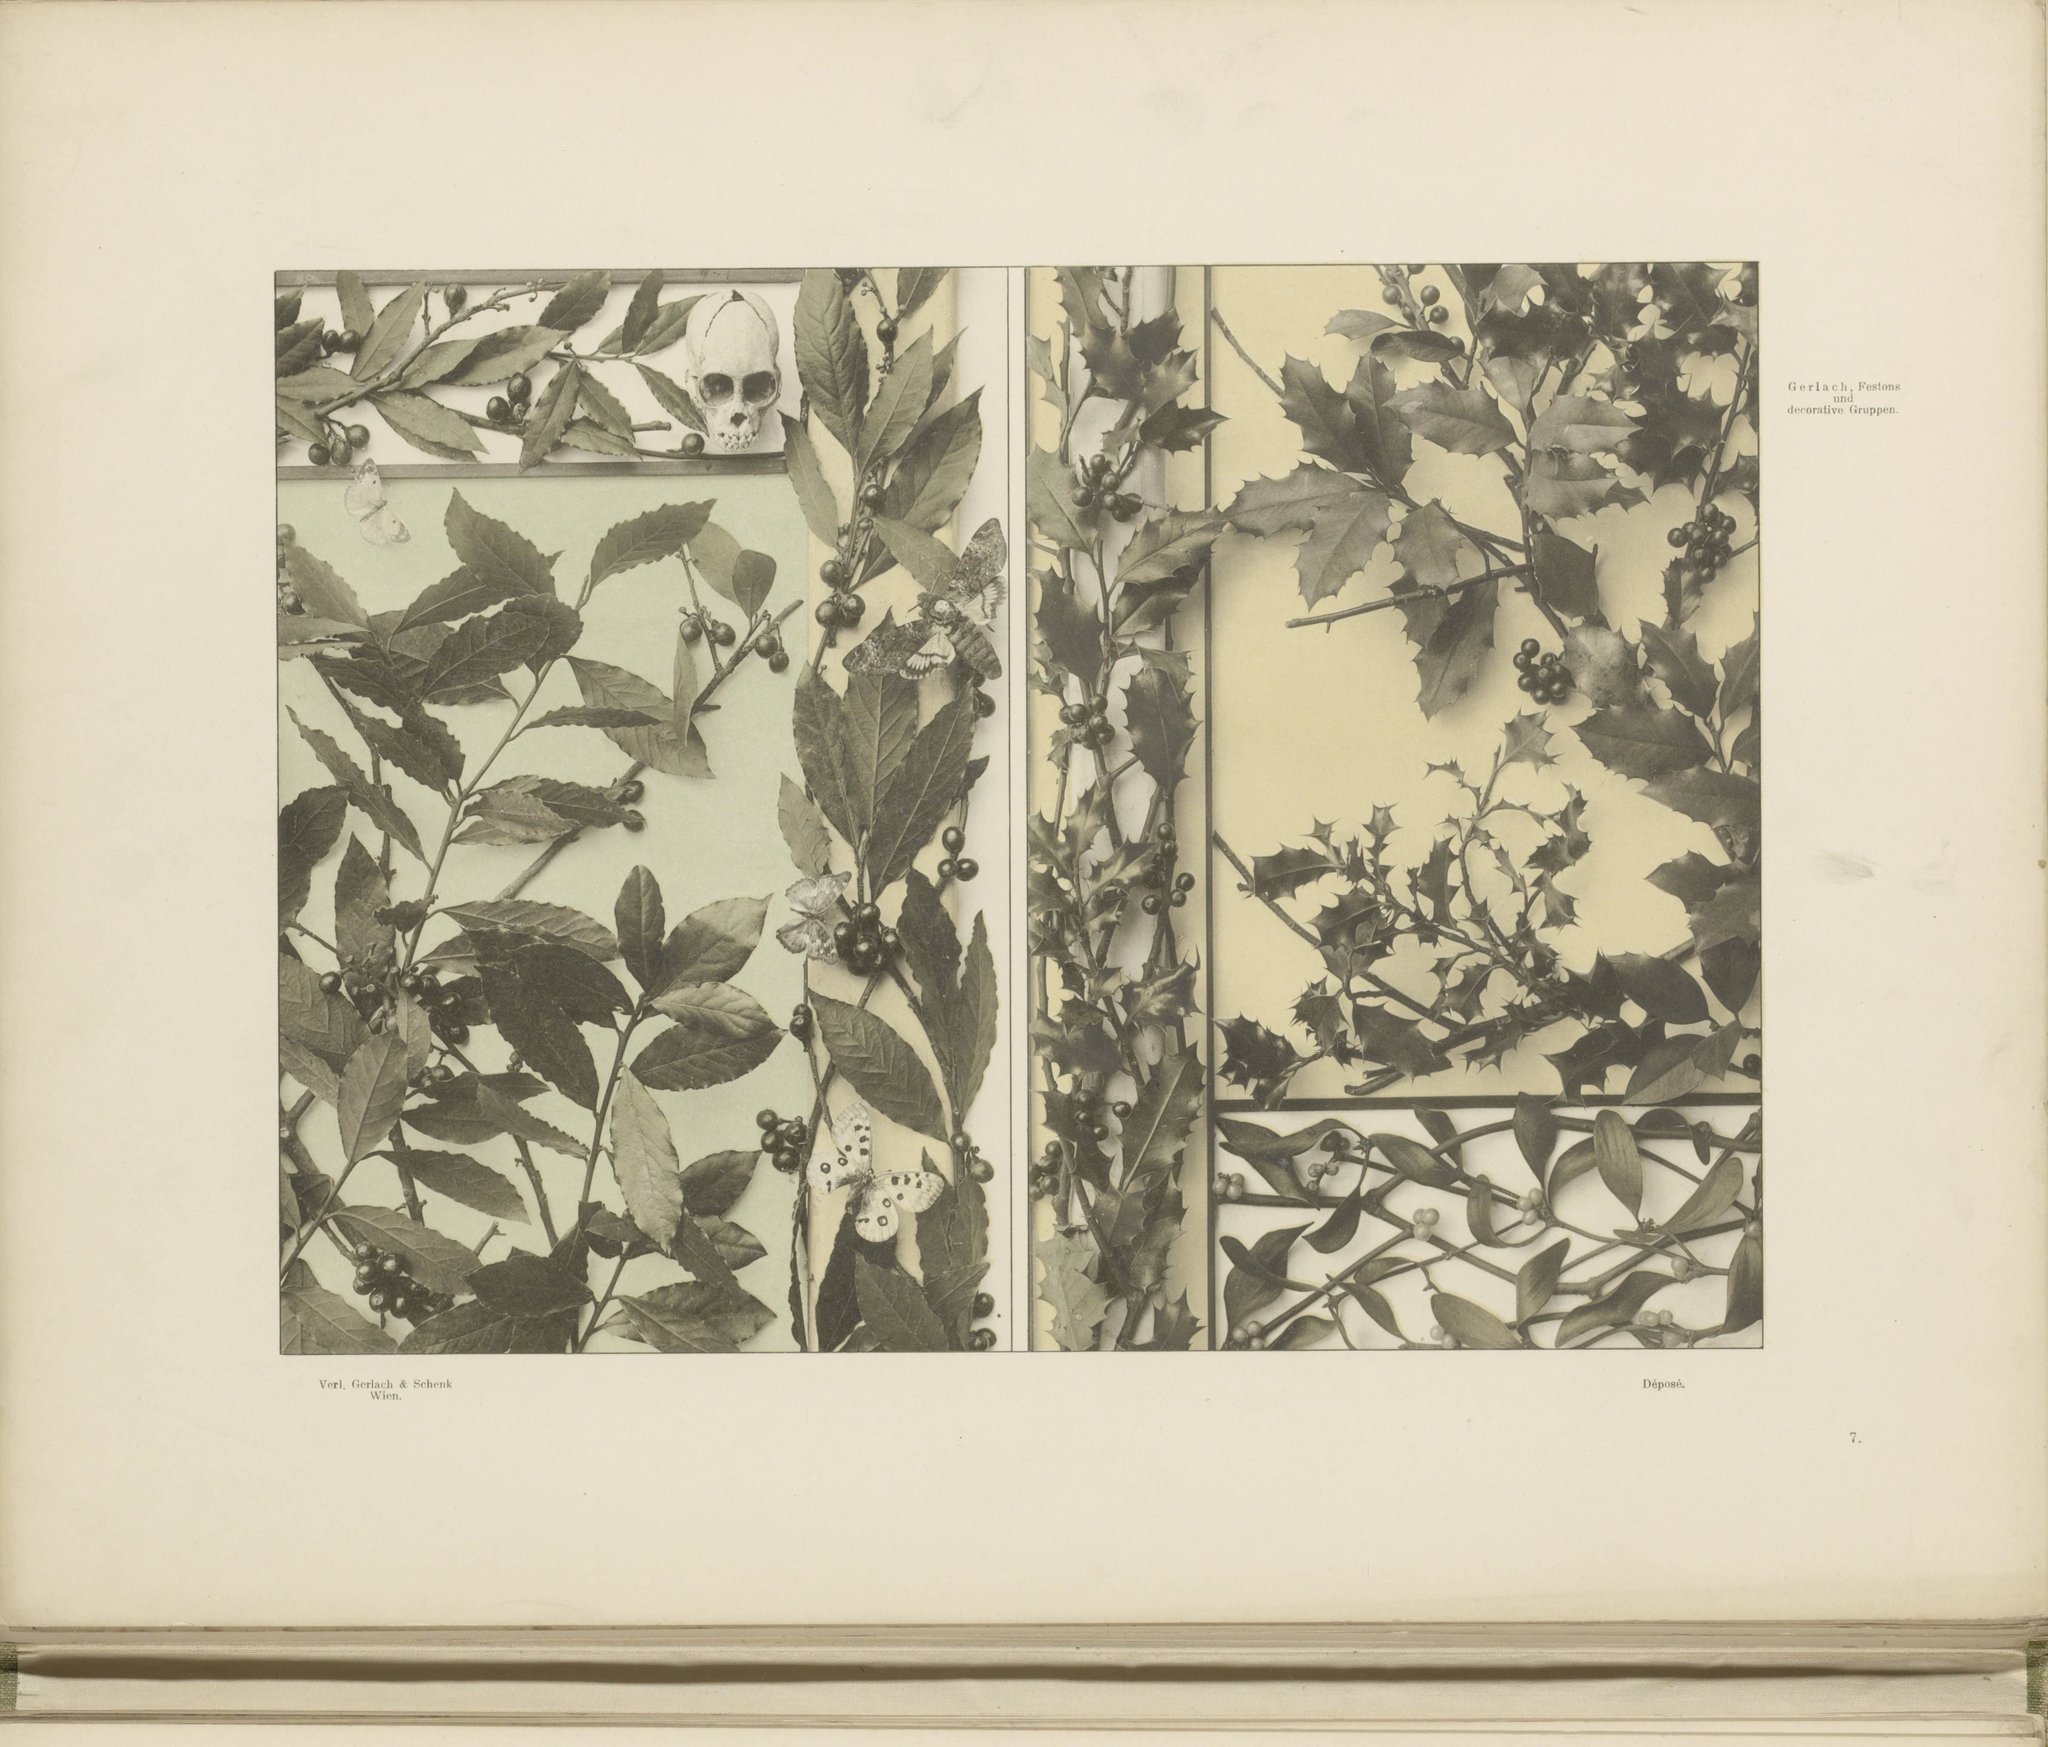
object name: photomechanical print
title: Vlakvullingen van laurier en vlinders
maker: Anonymous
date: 1887-1897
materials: paper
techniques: photograph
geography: vienna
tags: trees: laurel (branch, stick), animals (+ skull of an animal), insects: butterfly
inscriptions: number: ‘7.’